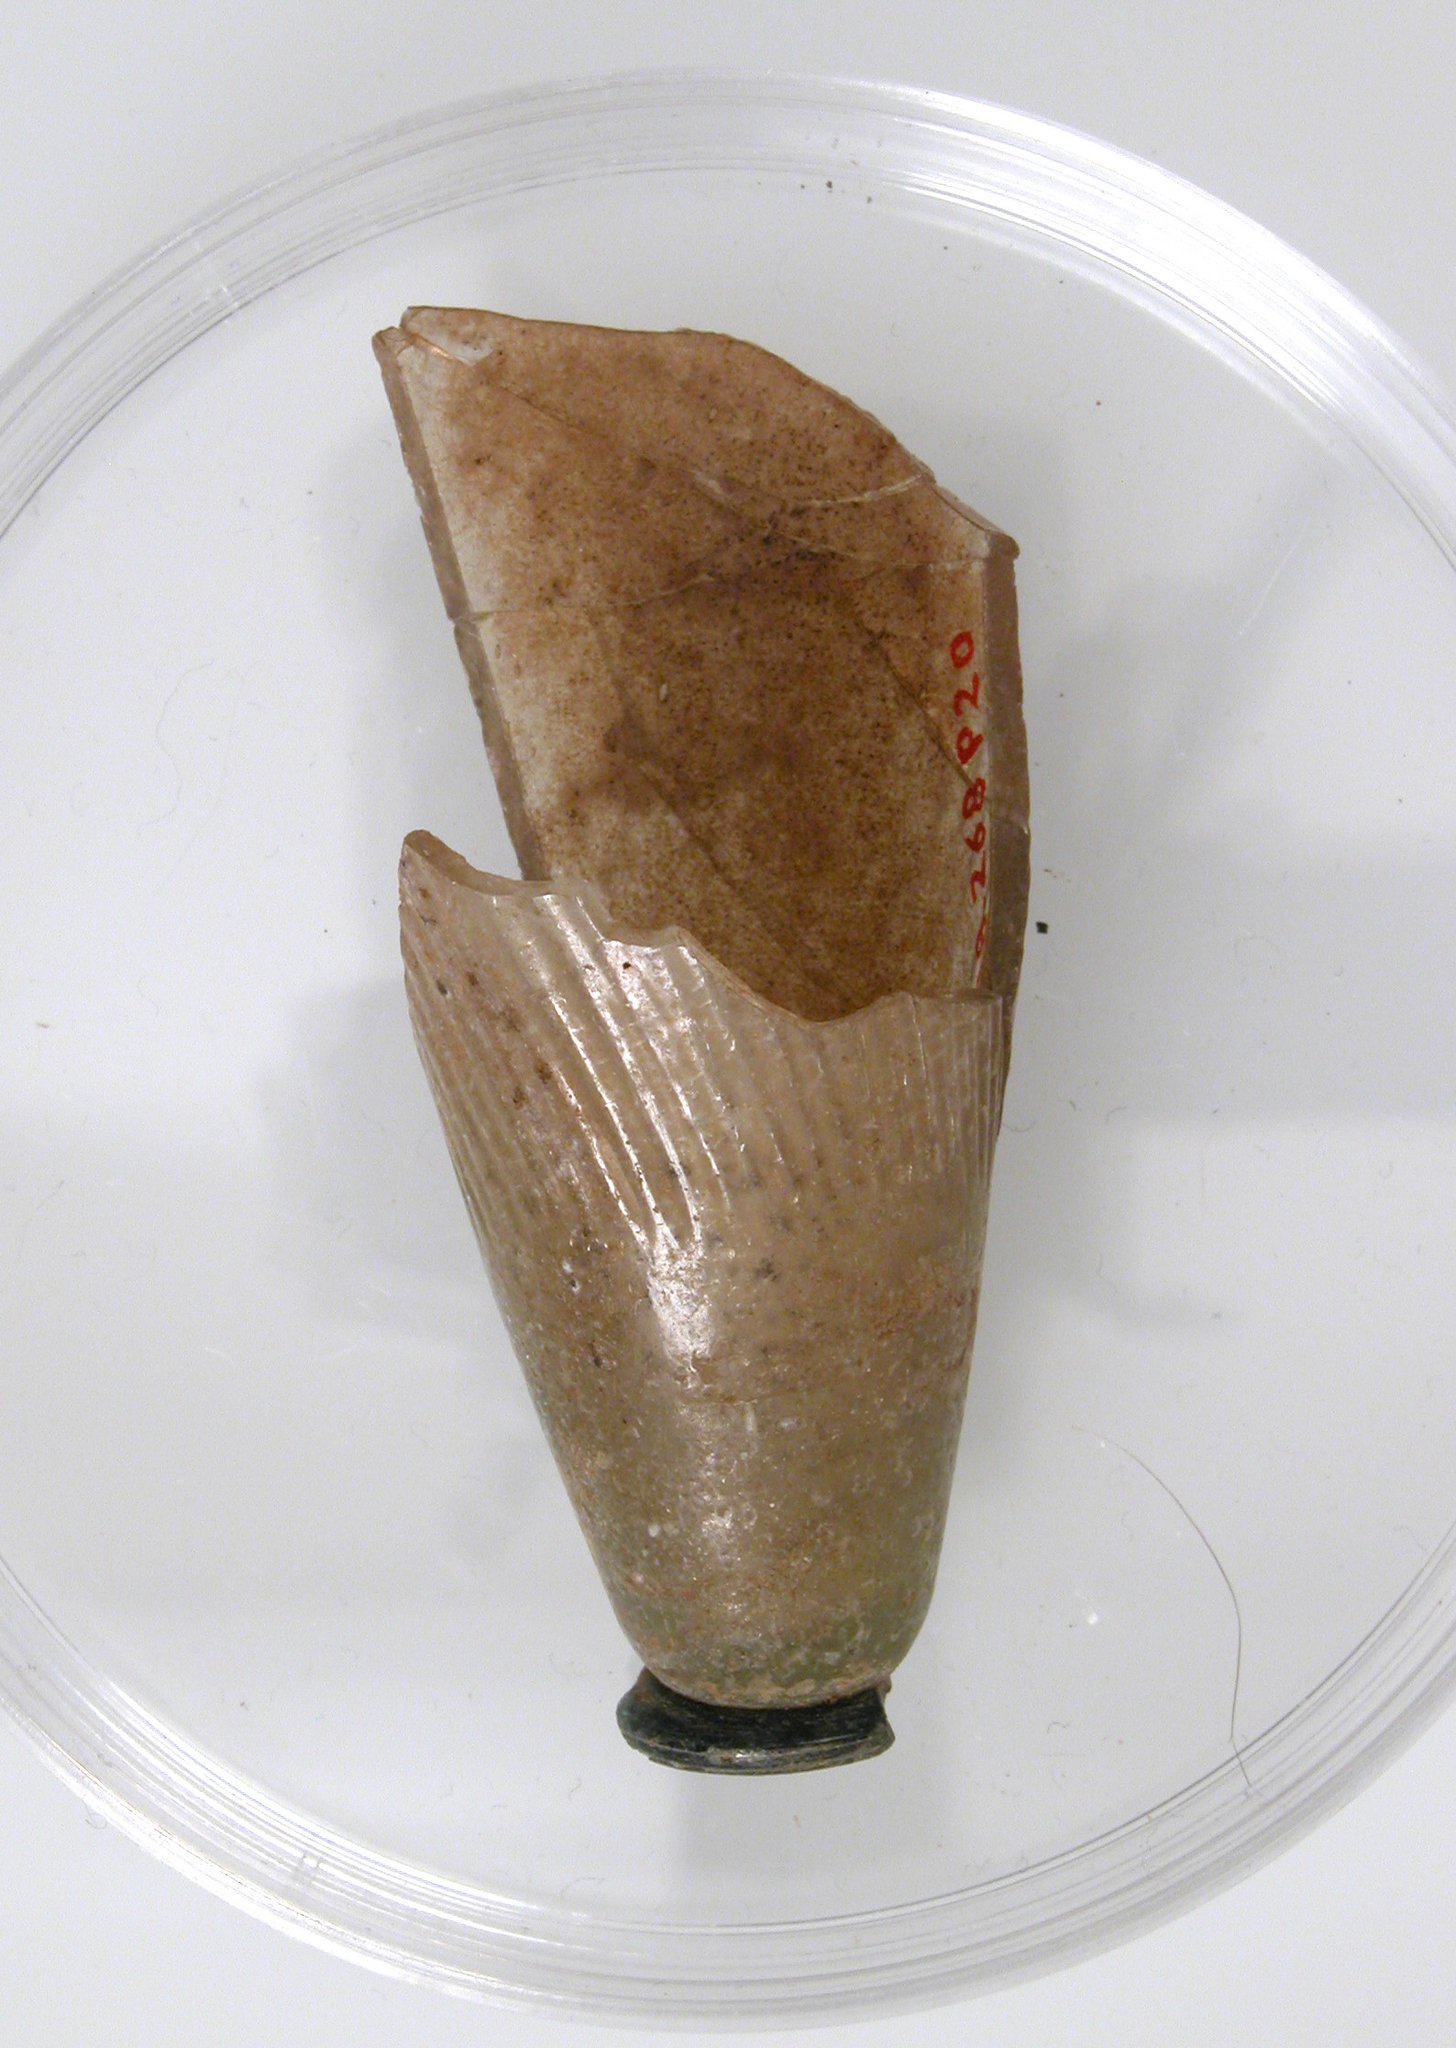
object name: fragment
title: Glass Fragment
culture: coptic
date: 301-433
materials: glass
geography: egypt